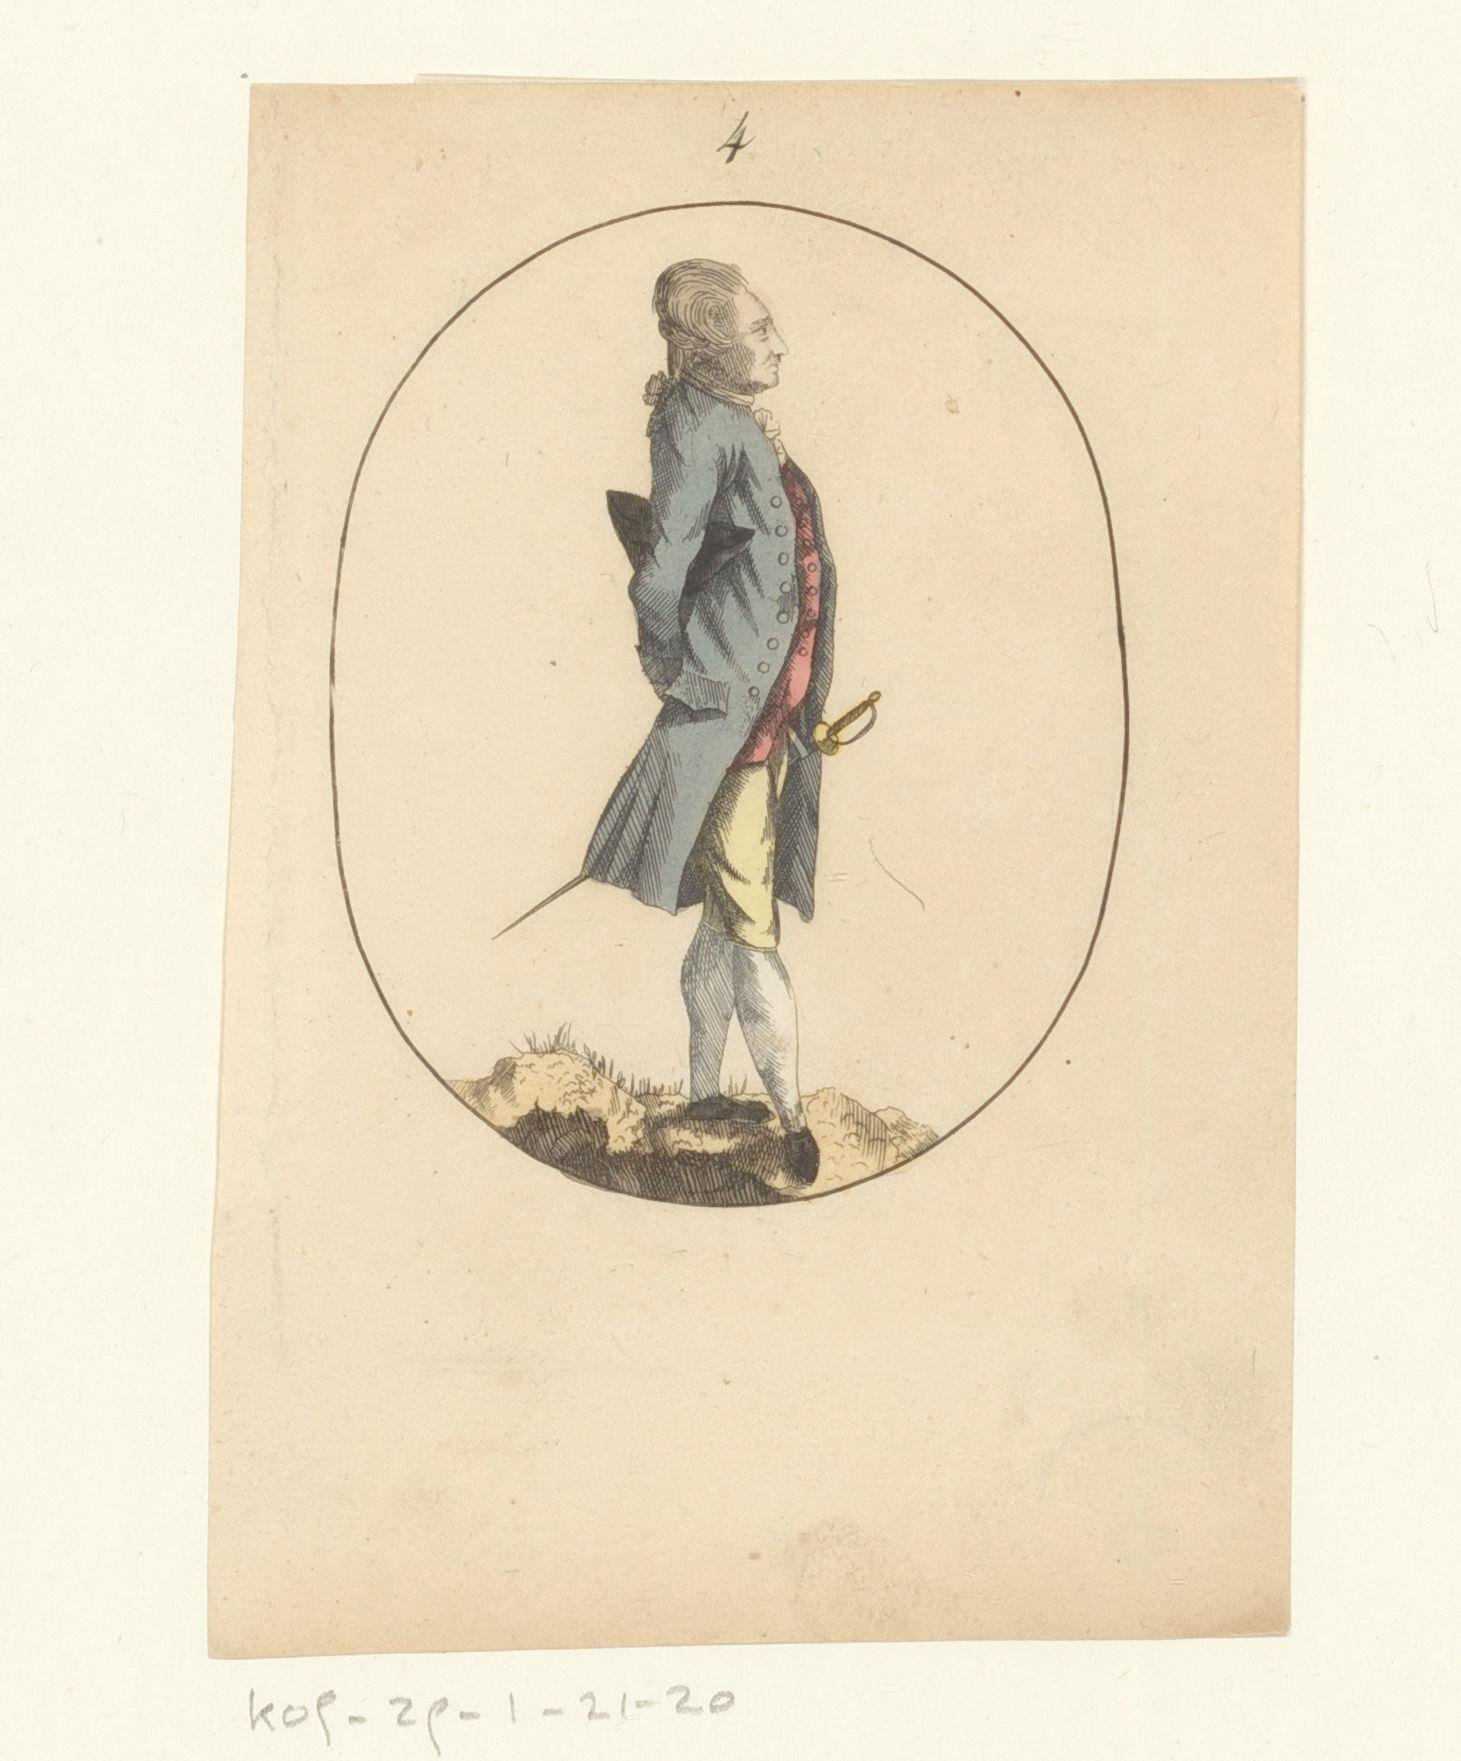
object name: print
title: Man met zijn handen op zijn rug en steek onder zijn arm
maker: Anonymous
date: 1750-1849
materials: paper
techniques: etching, hand coloring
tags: head-gear: tricorn, coat, historical costume, contemplation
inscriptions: collector's mark: Lugt 1641a, stamp, collector's mark: Lugt 1641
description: Bovenaan genummerd: 4. Onderwerpsrubrieken binnen de Atlas Zeden en Gewoonten: Zeden en Gewoonten in Engeren Zin, De Kleeding, Kleederdrachten (tijdvakken), De 18de eeuw (de pruikentijd). Mannen en vrouwen.